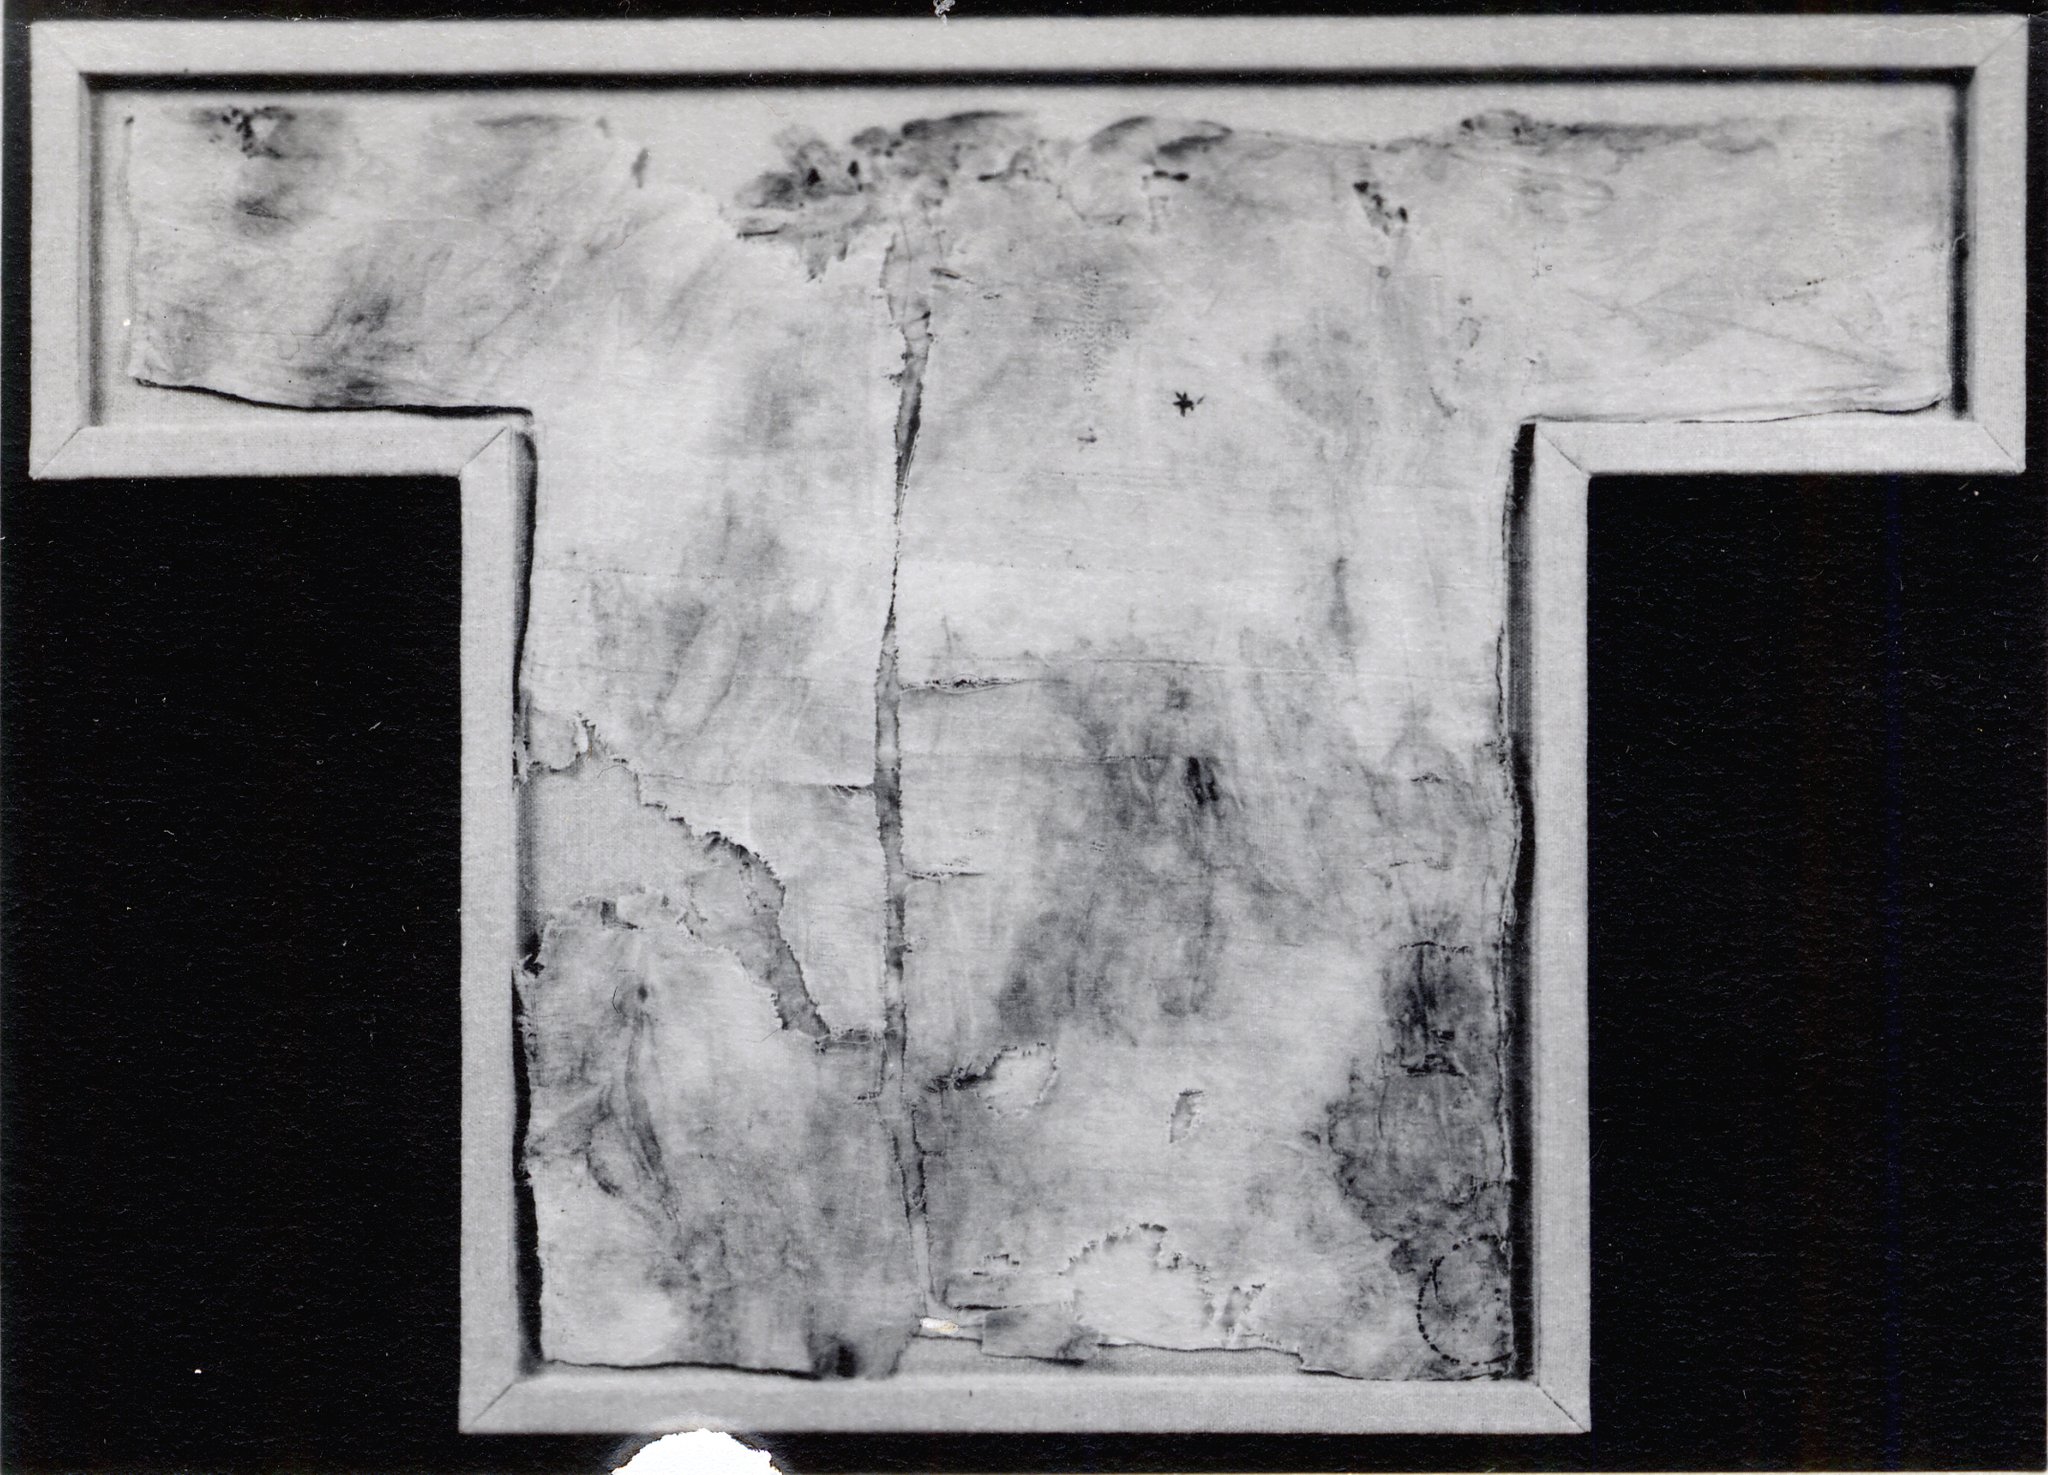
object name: dress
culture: coptic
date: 301-400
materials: linen, wool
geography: egypt